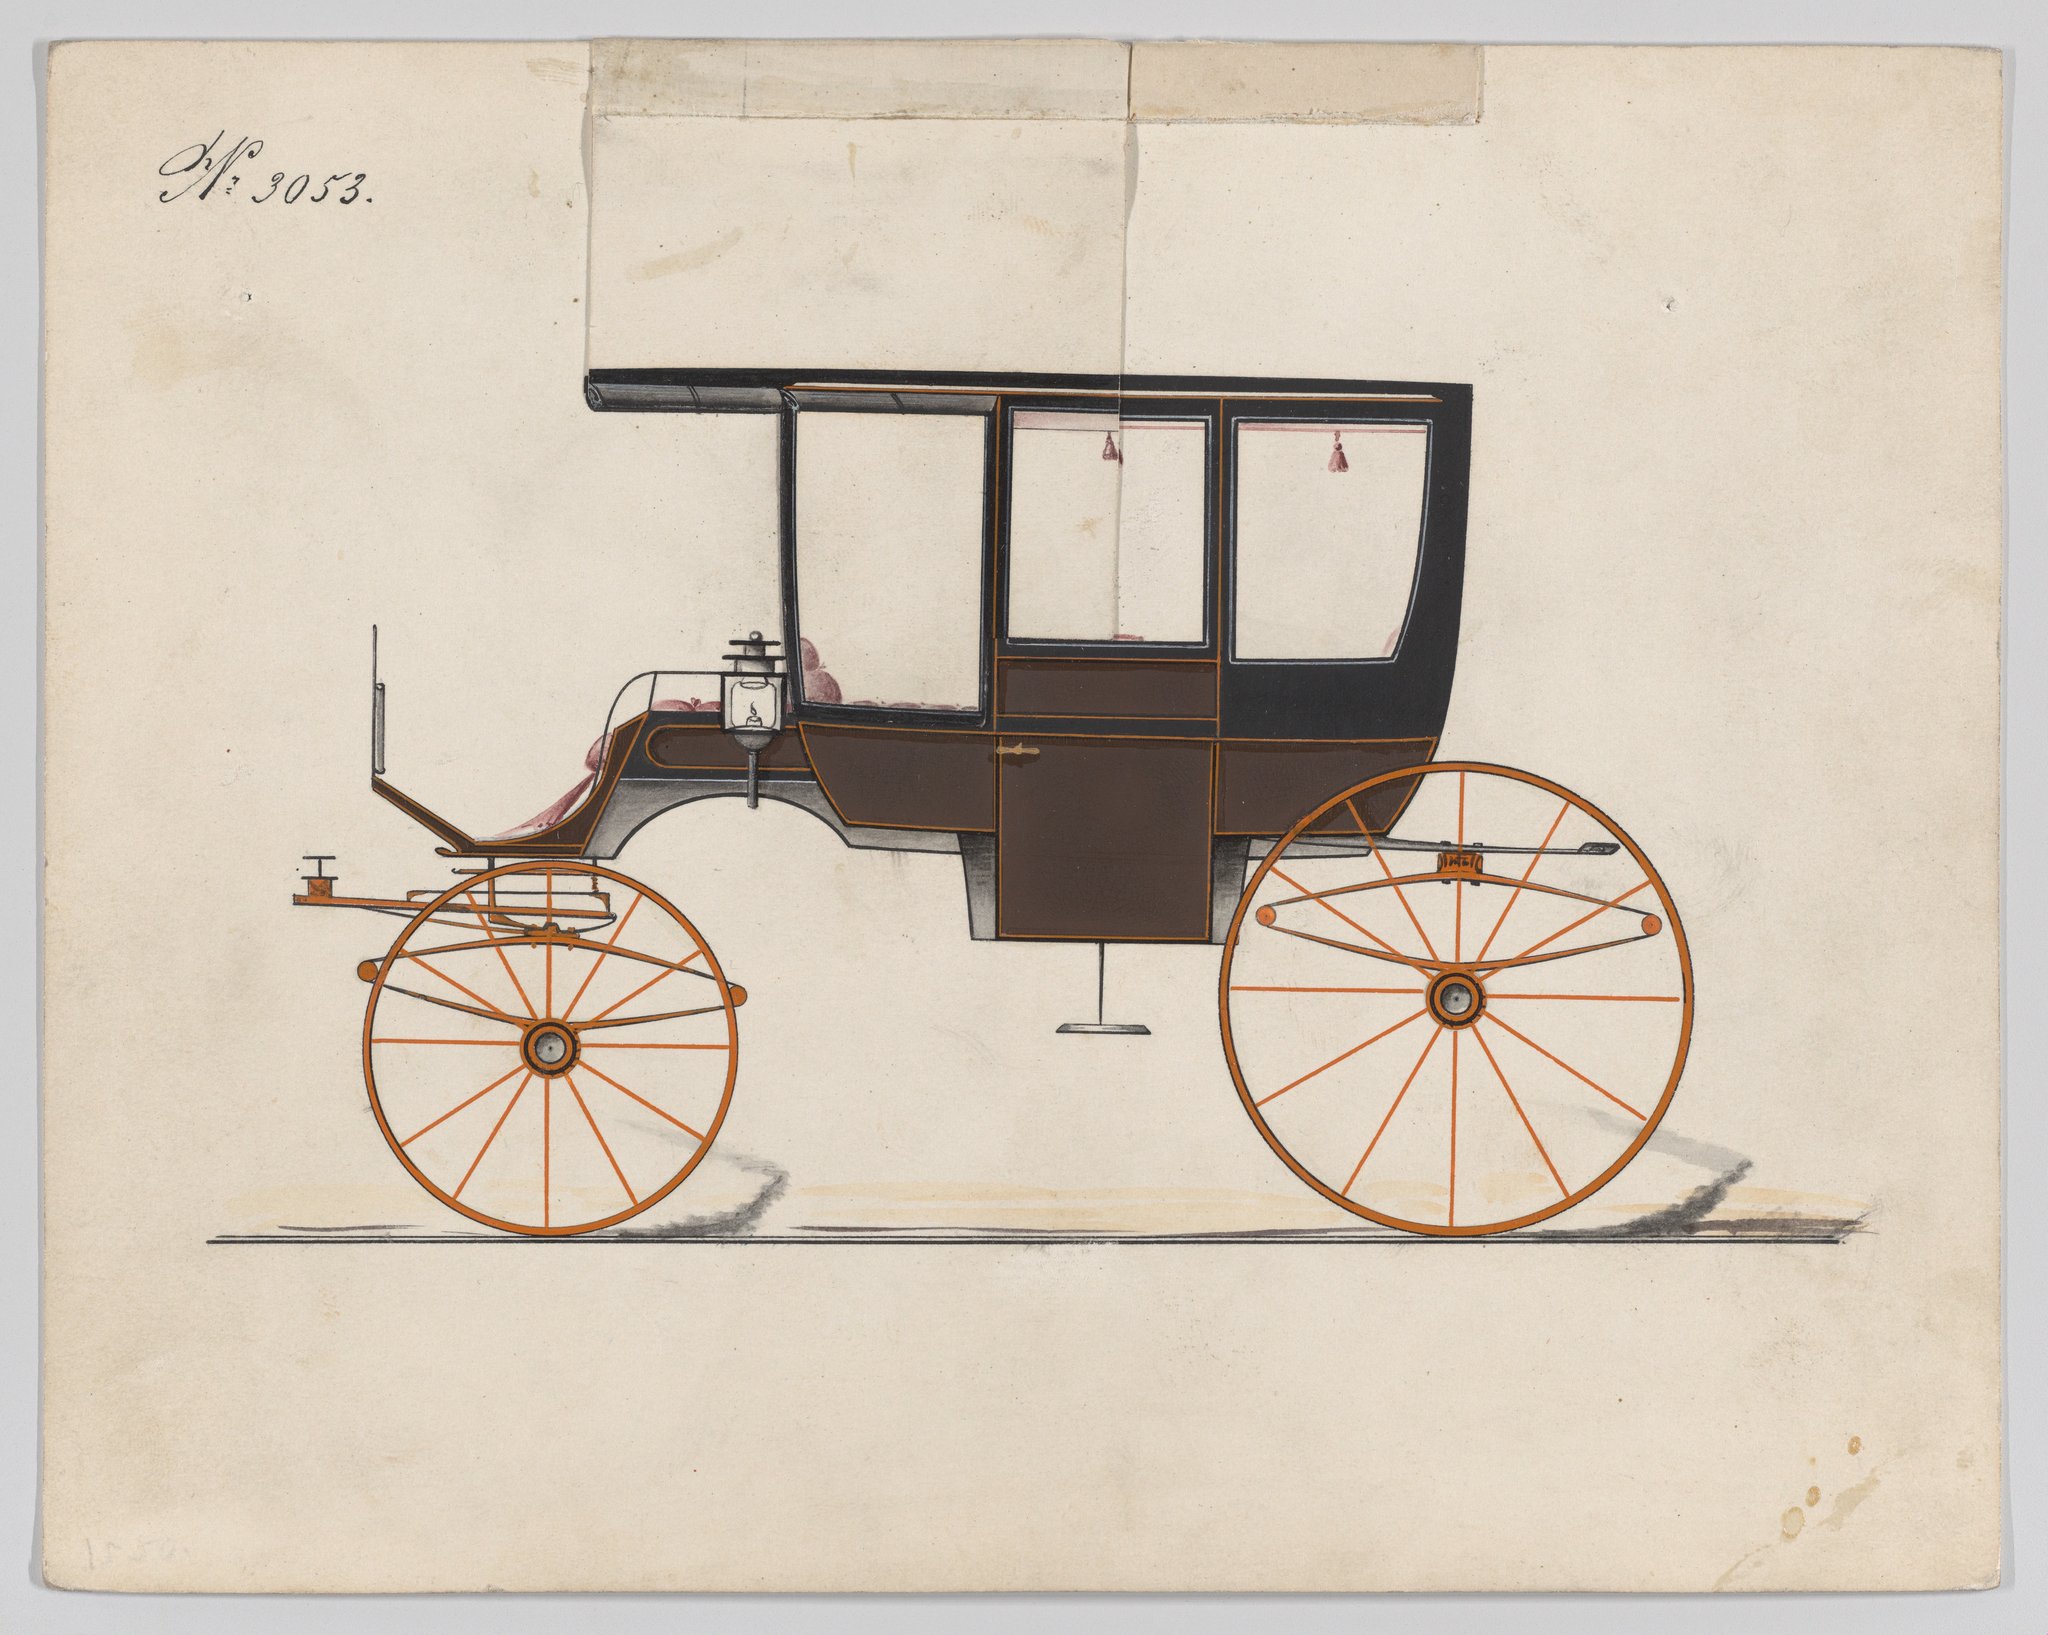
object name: drawing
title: Design for 6 seat Rockaway, no. 3053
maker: brewster & co.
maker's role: manufacturer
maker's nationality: american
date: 1874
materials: gouache, gum arabic, ink, watercolor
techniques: pen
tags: carriages